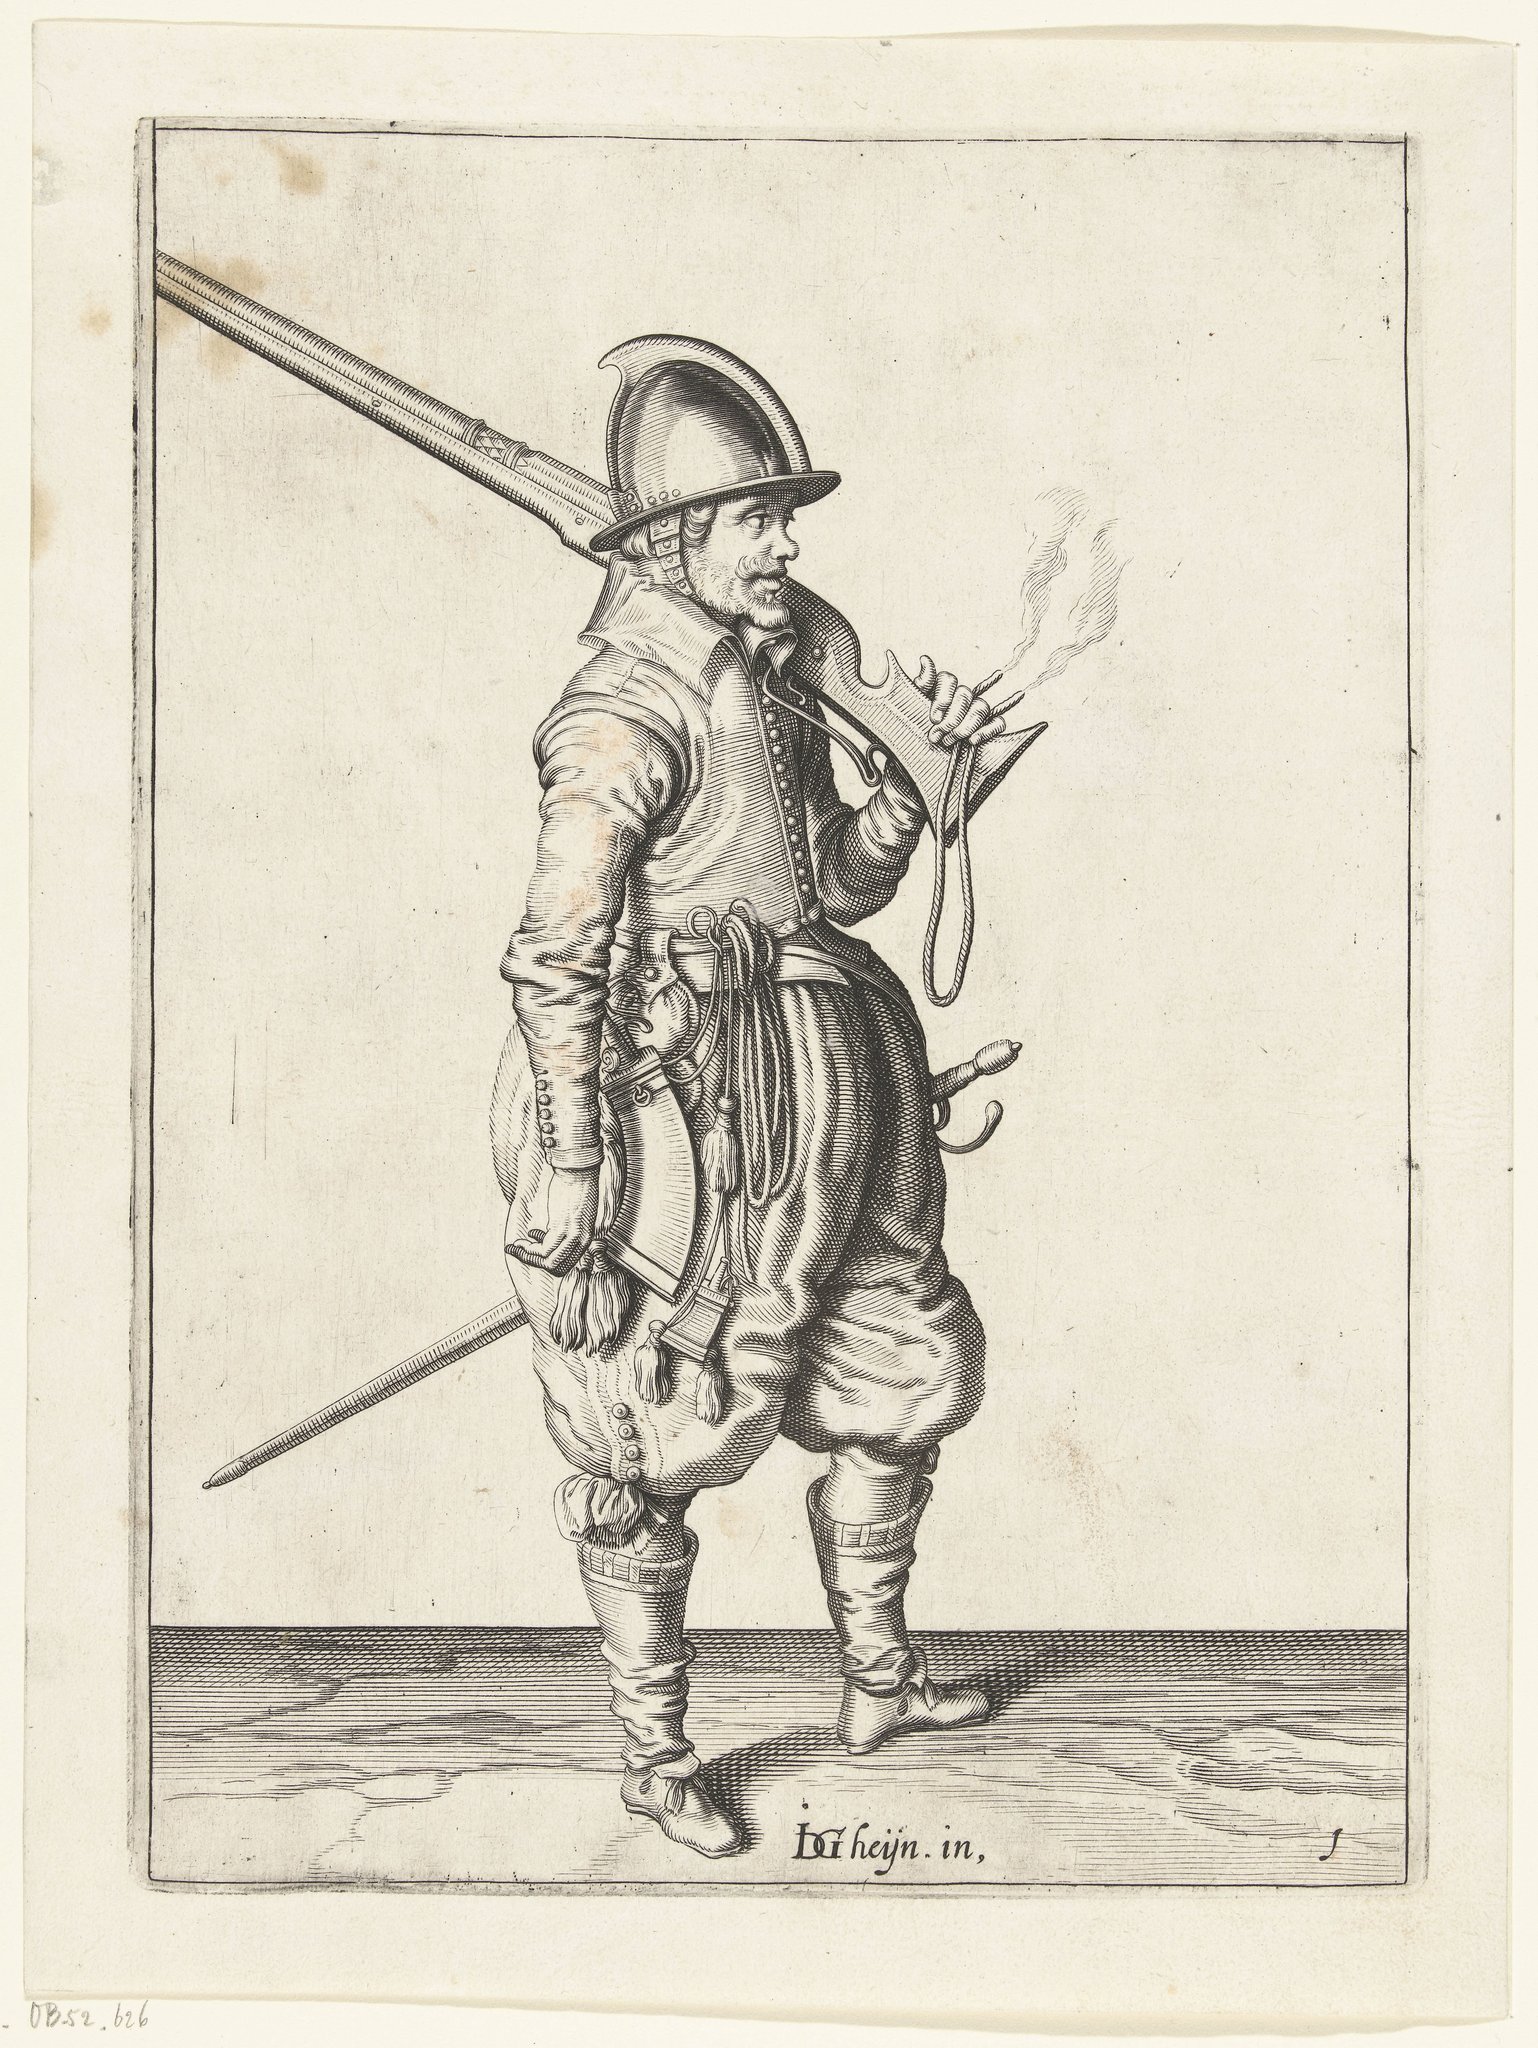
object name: print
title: Wapenhandelinghe van Roers Musquetten ende Spiessen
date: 1597-1607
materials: paper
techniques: engraving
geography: netherlands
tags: manoeuvre ~ military training, firearms: rifle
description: Een soldaat, ten voeten uit, naar rechts, met een roer (een bepaald type vuurwapen) steunend op zijn linkerschouder. In zijn linkerhand behalve de kolf van het roer ook een brandende lont. Deze prent is onderdeel van de reeks van 42 genummerde prenten van roerschutters uit de Wapenhandelinghe.